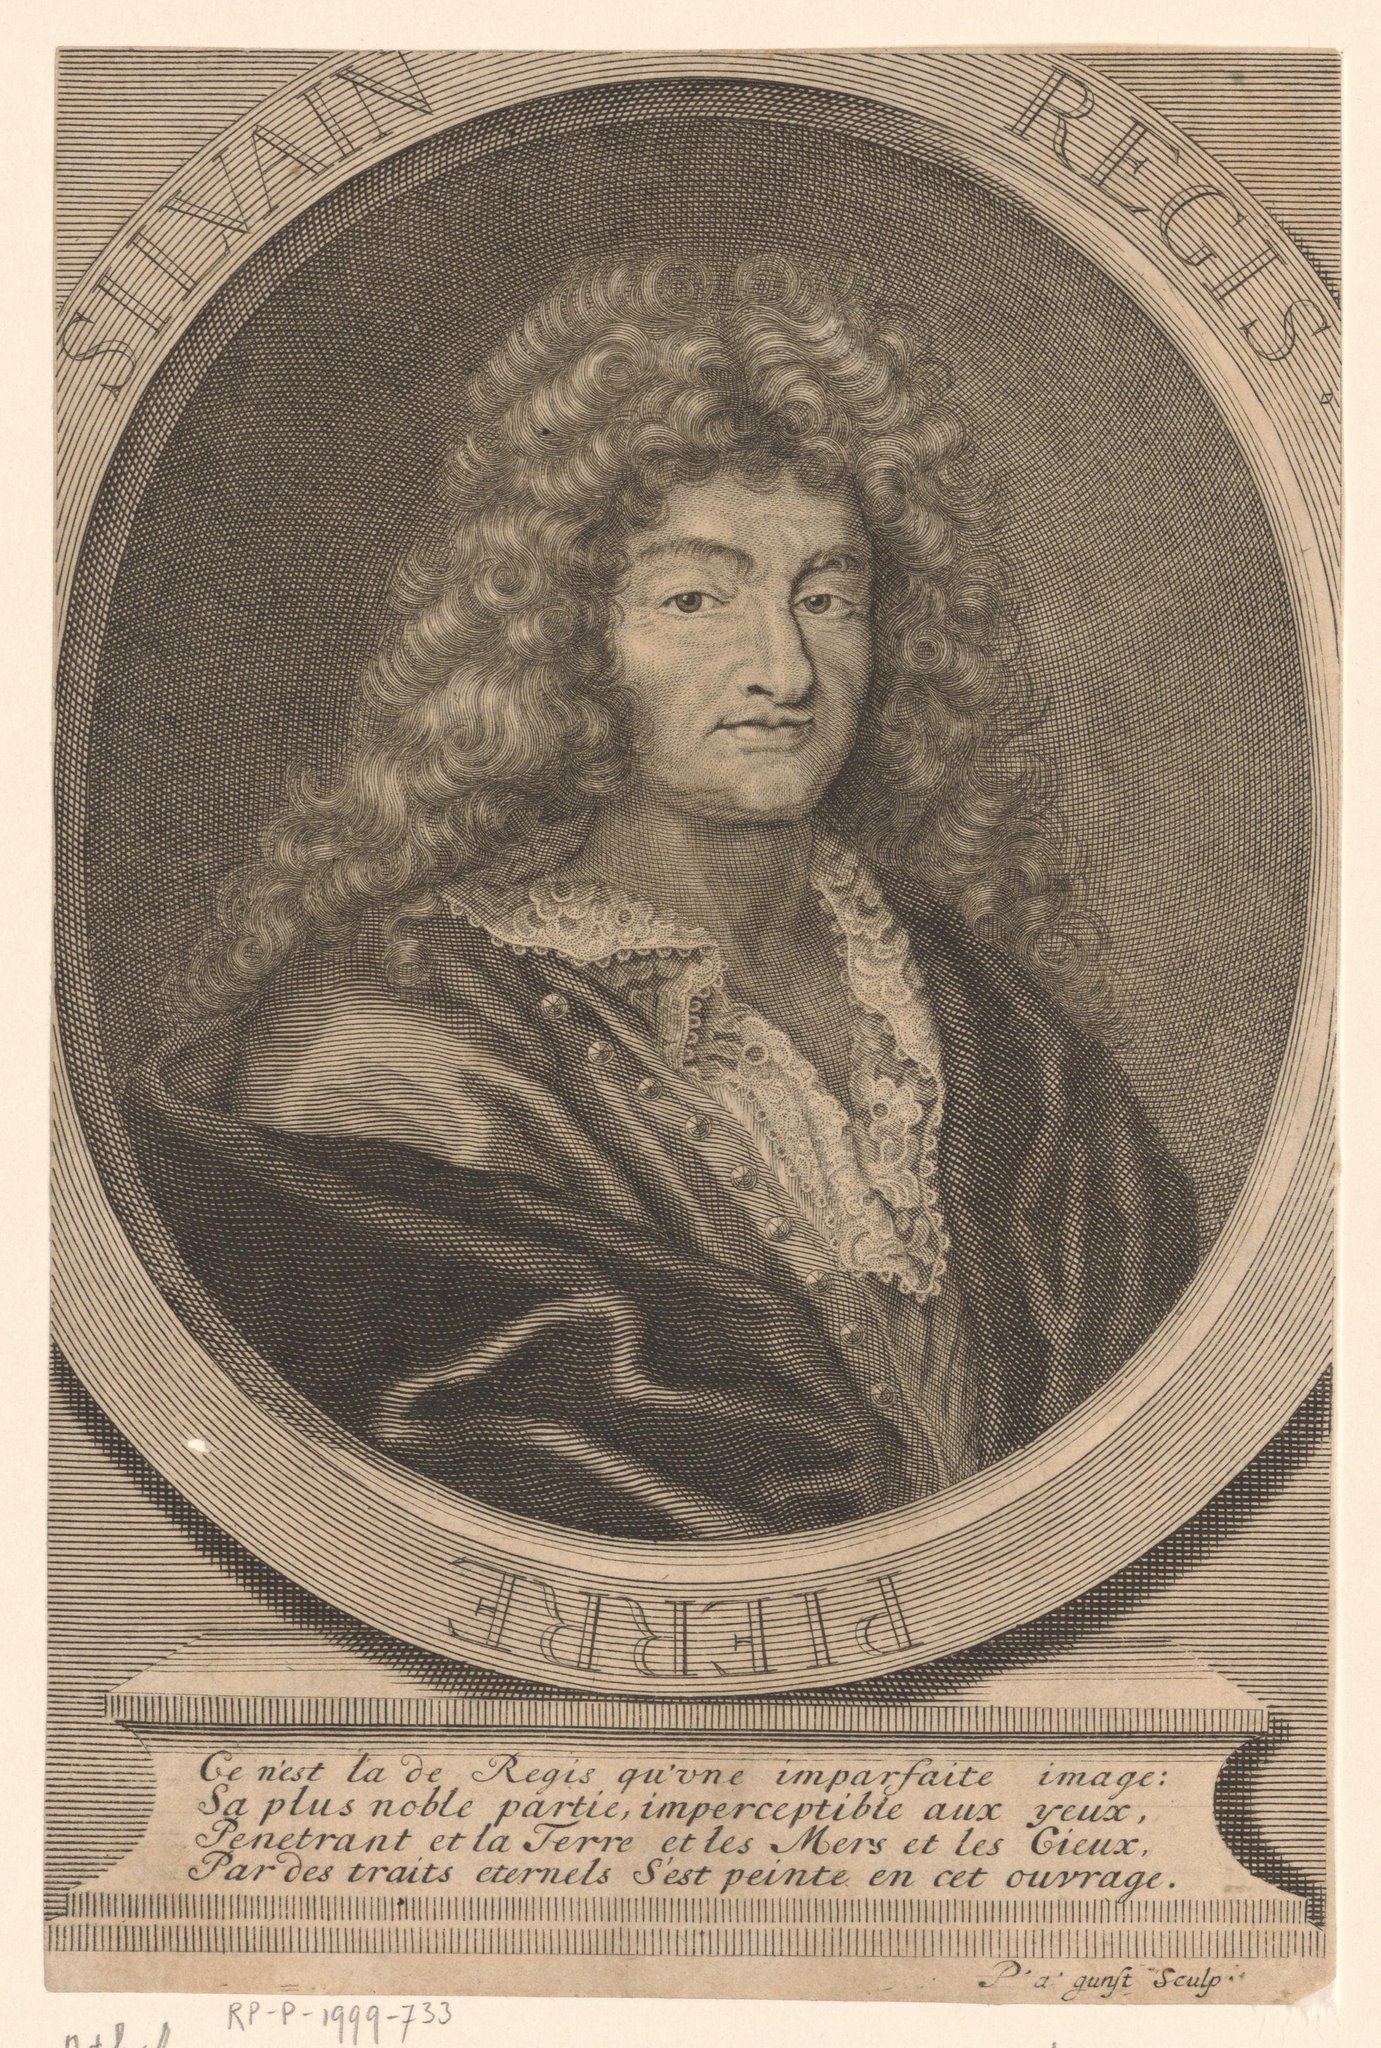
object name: print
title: Portret van Pierre-Silvain Régis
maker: pieter van gunst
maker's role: print maker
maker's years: 1658-1731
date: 1690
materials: paper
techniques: engraving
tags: paris, historical persons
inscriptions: collector's mark: Lugt 2228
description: Prent mogelijk uit: Régis, Pierre-Silvain. Systeme de philosophie (...). Parijs: Laurent Anisson, en Benoît Rigaud, 1690.